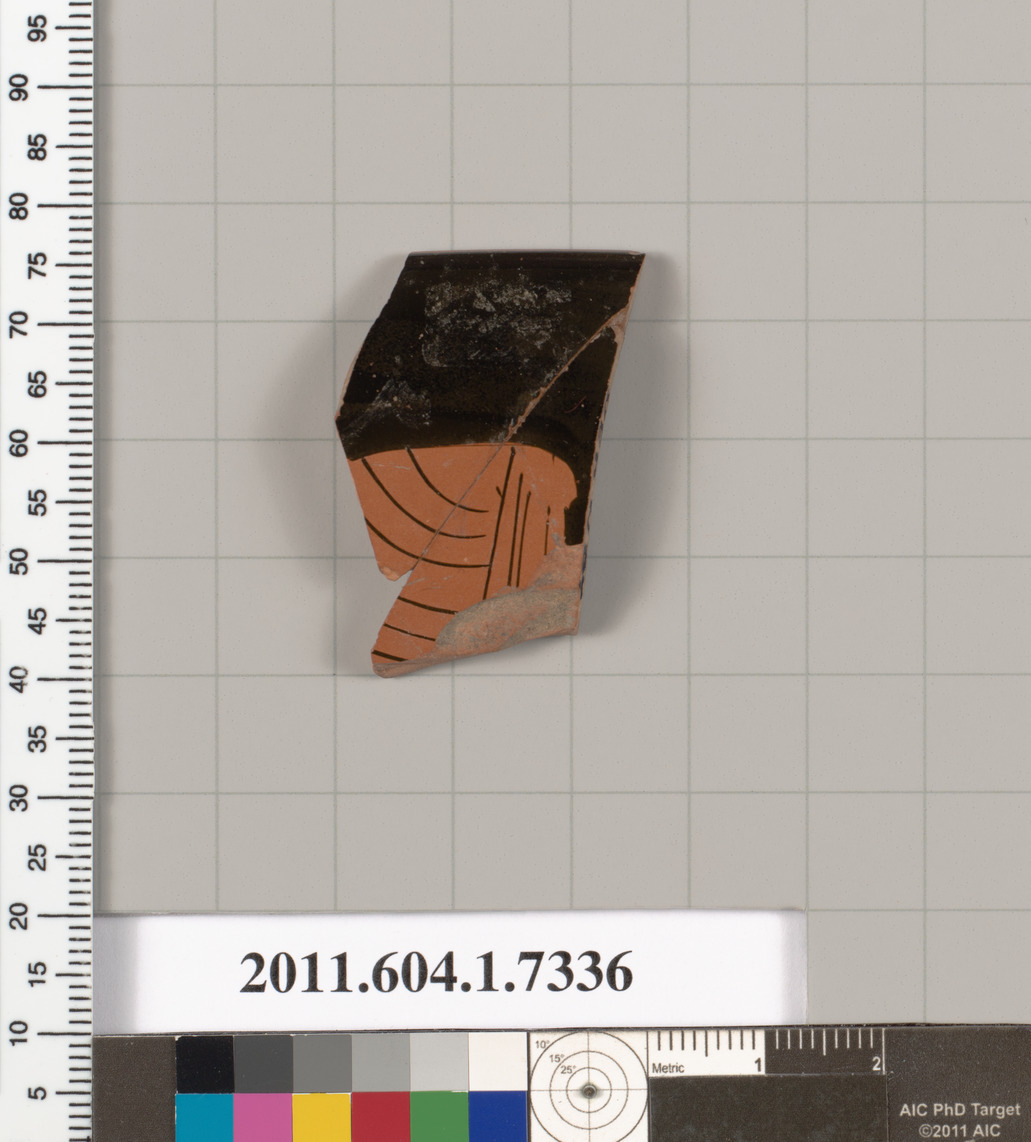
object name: kylix fragment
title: Terracotta rim fragment of a kylix (drinking cup)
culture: greek, attic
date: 500-480 BCE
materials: terracotta